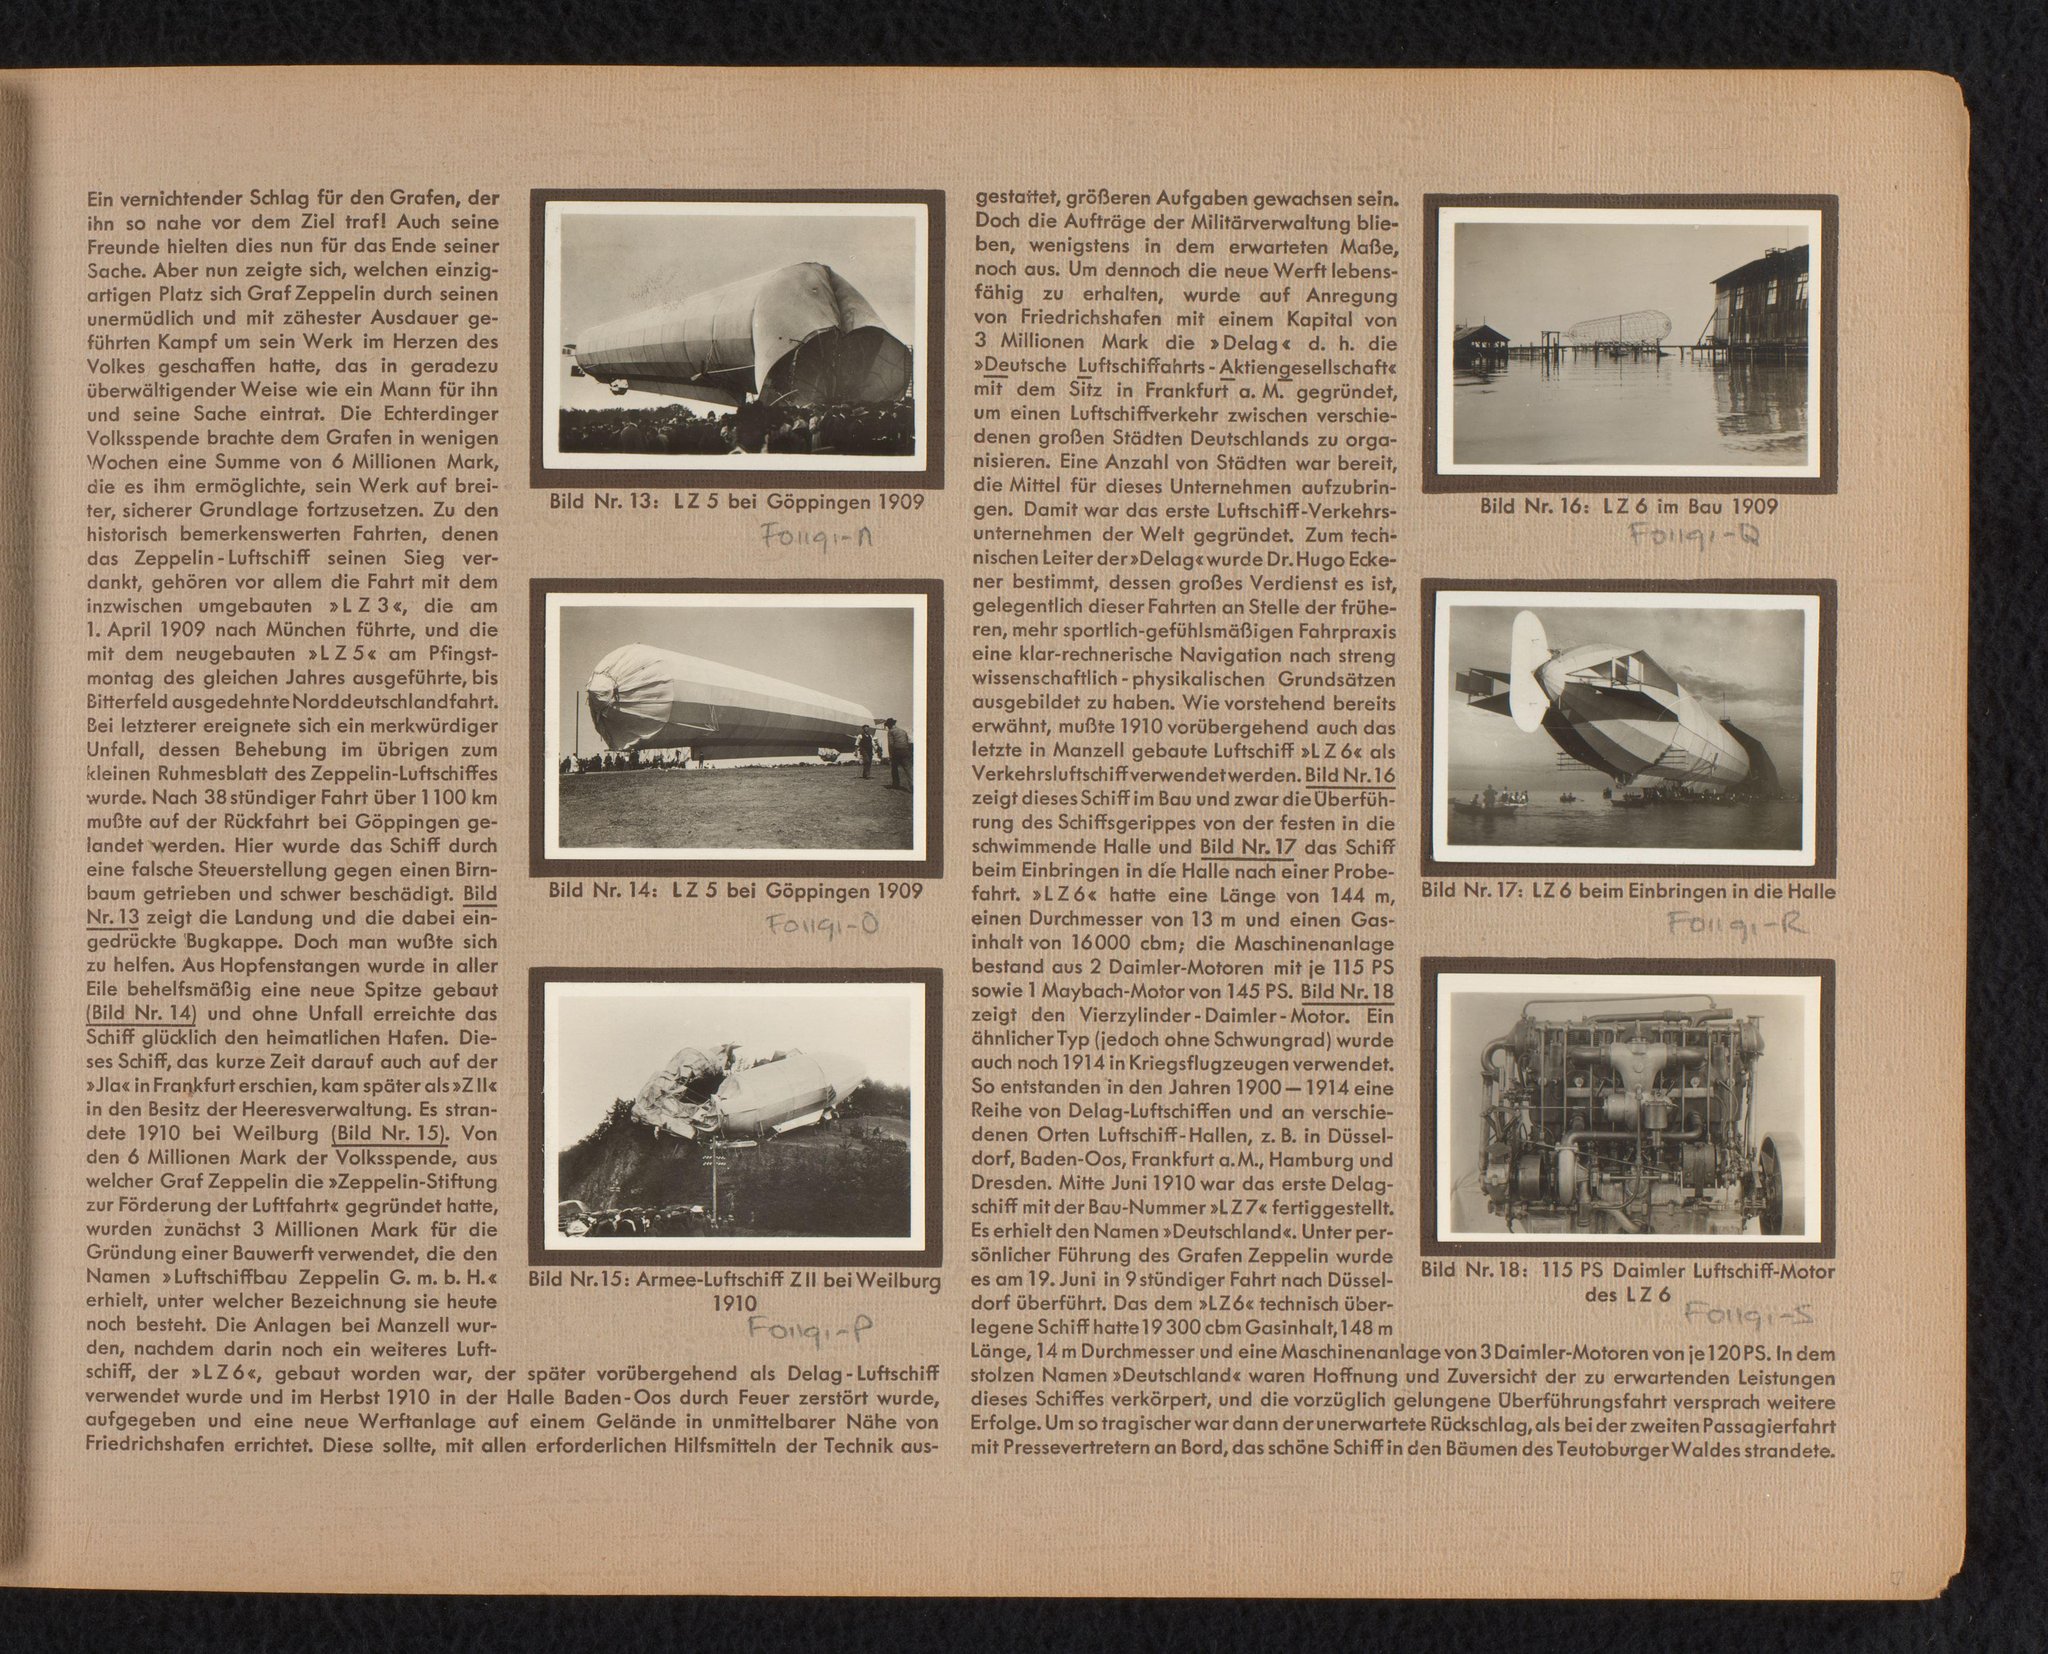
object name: photograph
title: Zeppelins LZ5 en LZ6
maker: Anonymous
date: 1909-1910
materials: paper, photographic support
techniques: gelatin silver print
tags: berlin, engineer, 46c35 airship, zeppelin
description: Pagina met zes foto's van onder meer LZ5 en LZ6. Alle foto's zijn voorzien van een nummer en titel. Deze pagina maakt deel uit van een album.